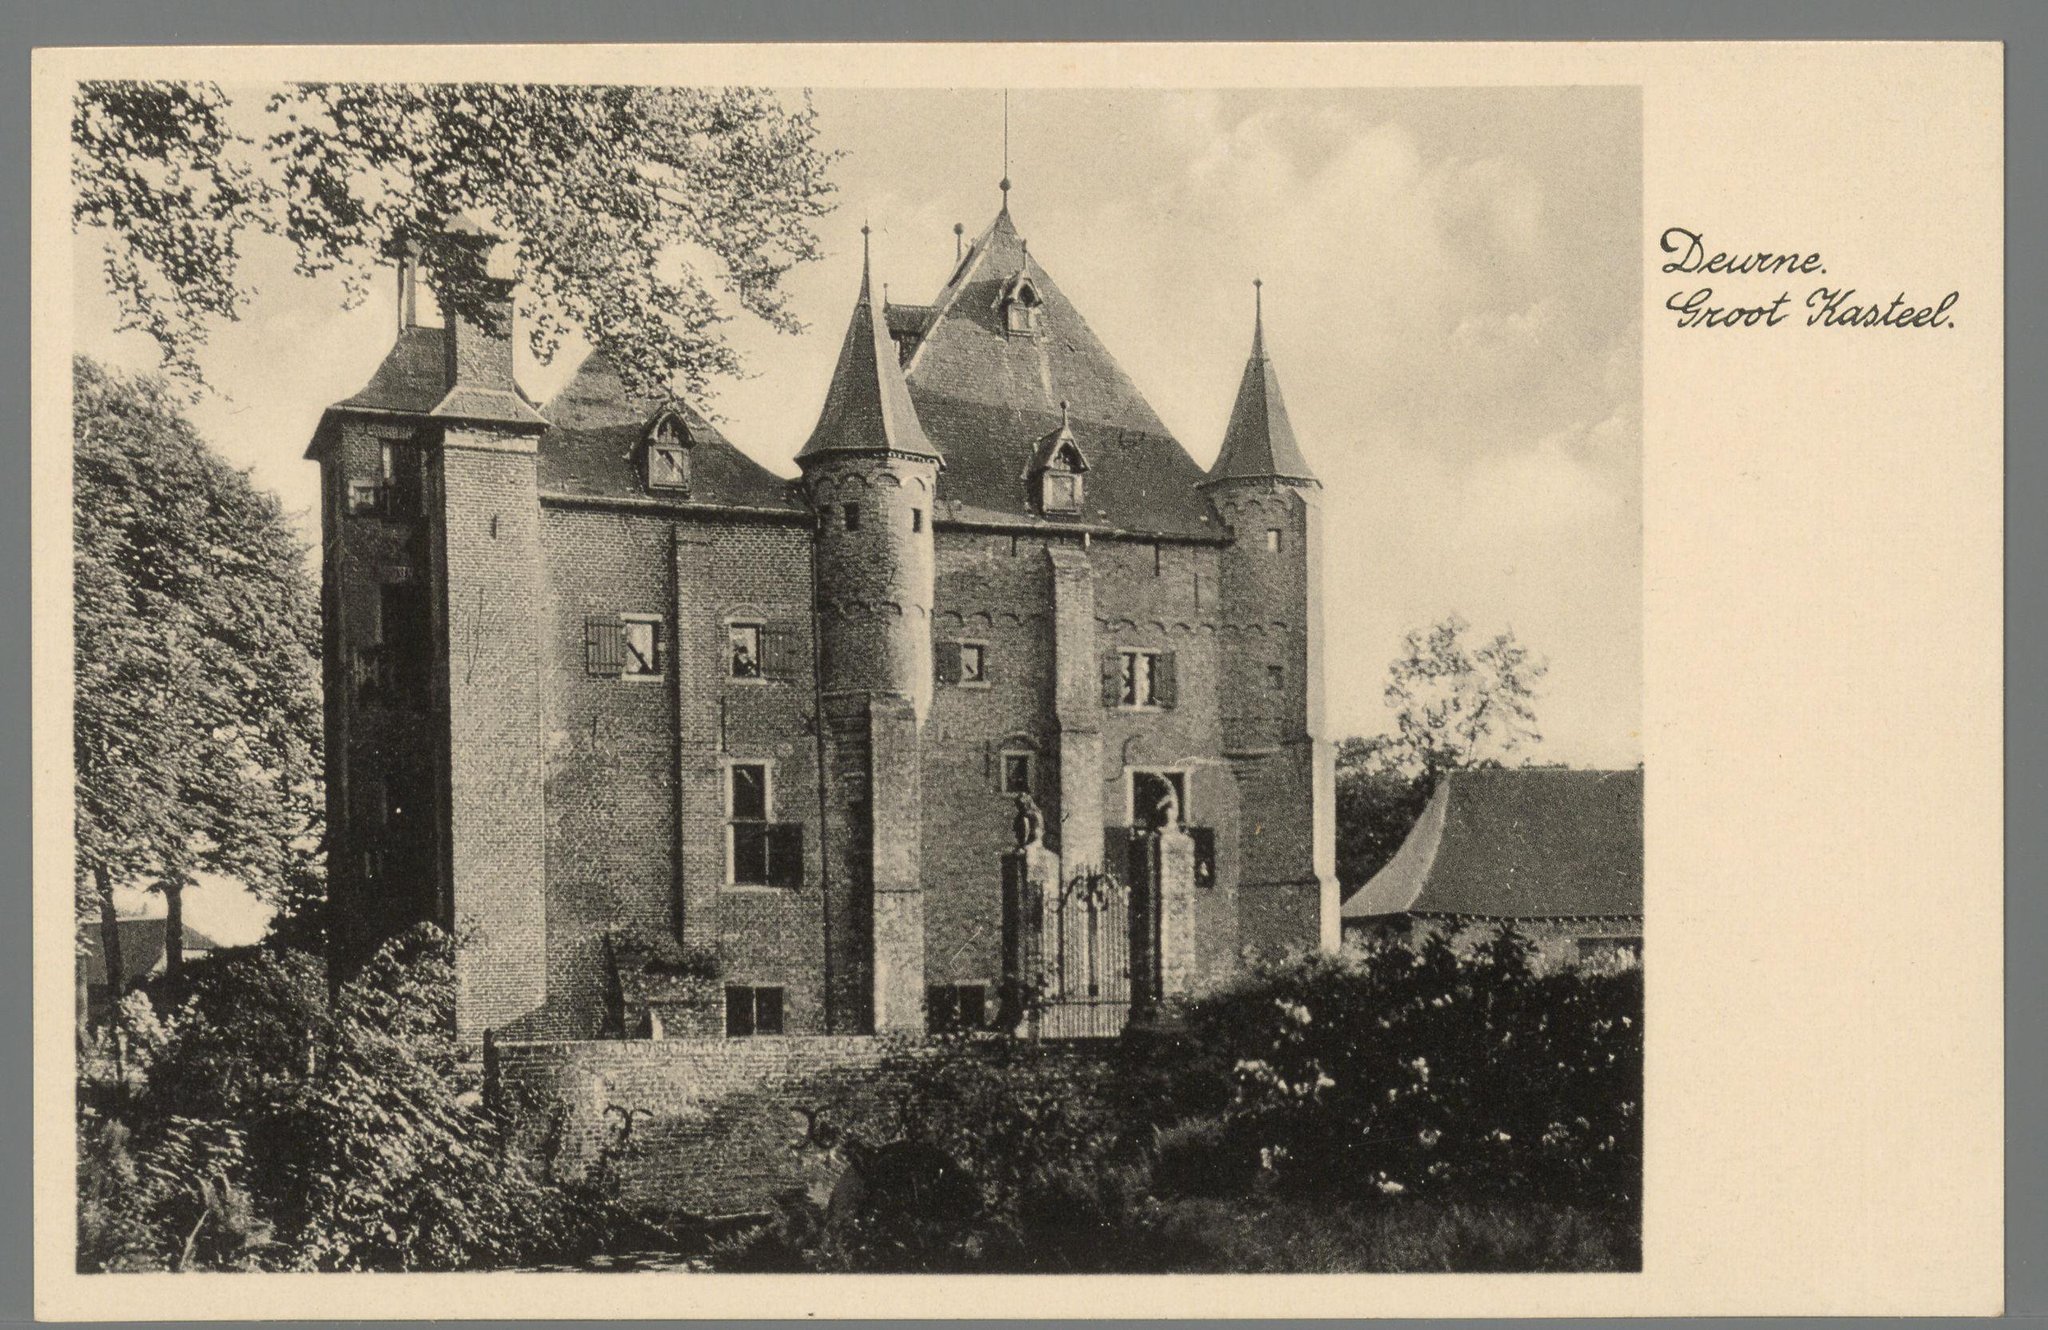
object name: photomechanical print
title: Deurne. Groot Kasteel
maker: Anonymous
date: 1930-1950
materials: cardboard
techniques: photograph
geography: deurne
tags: castle